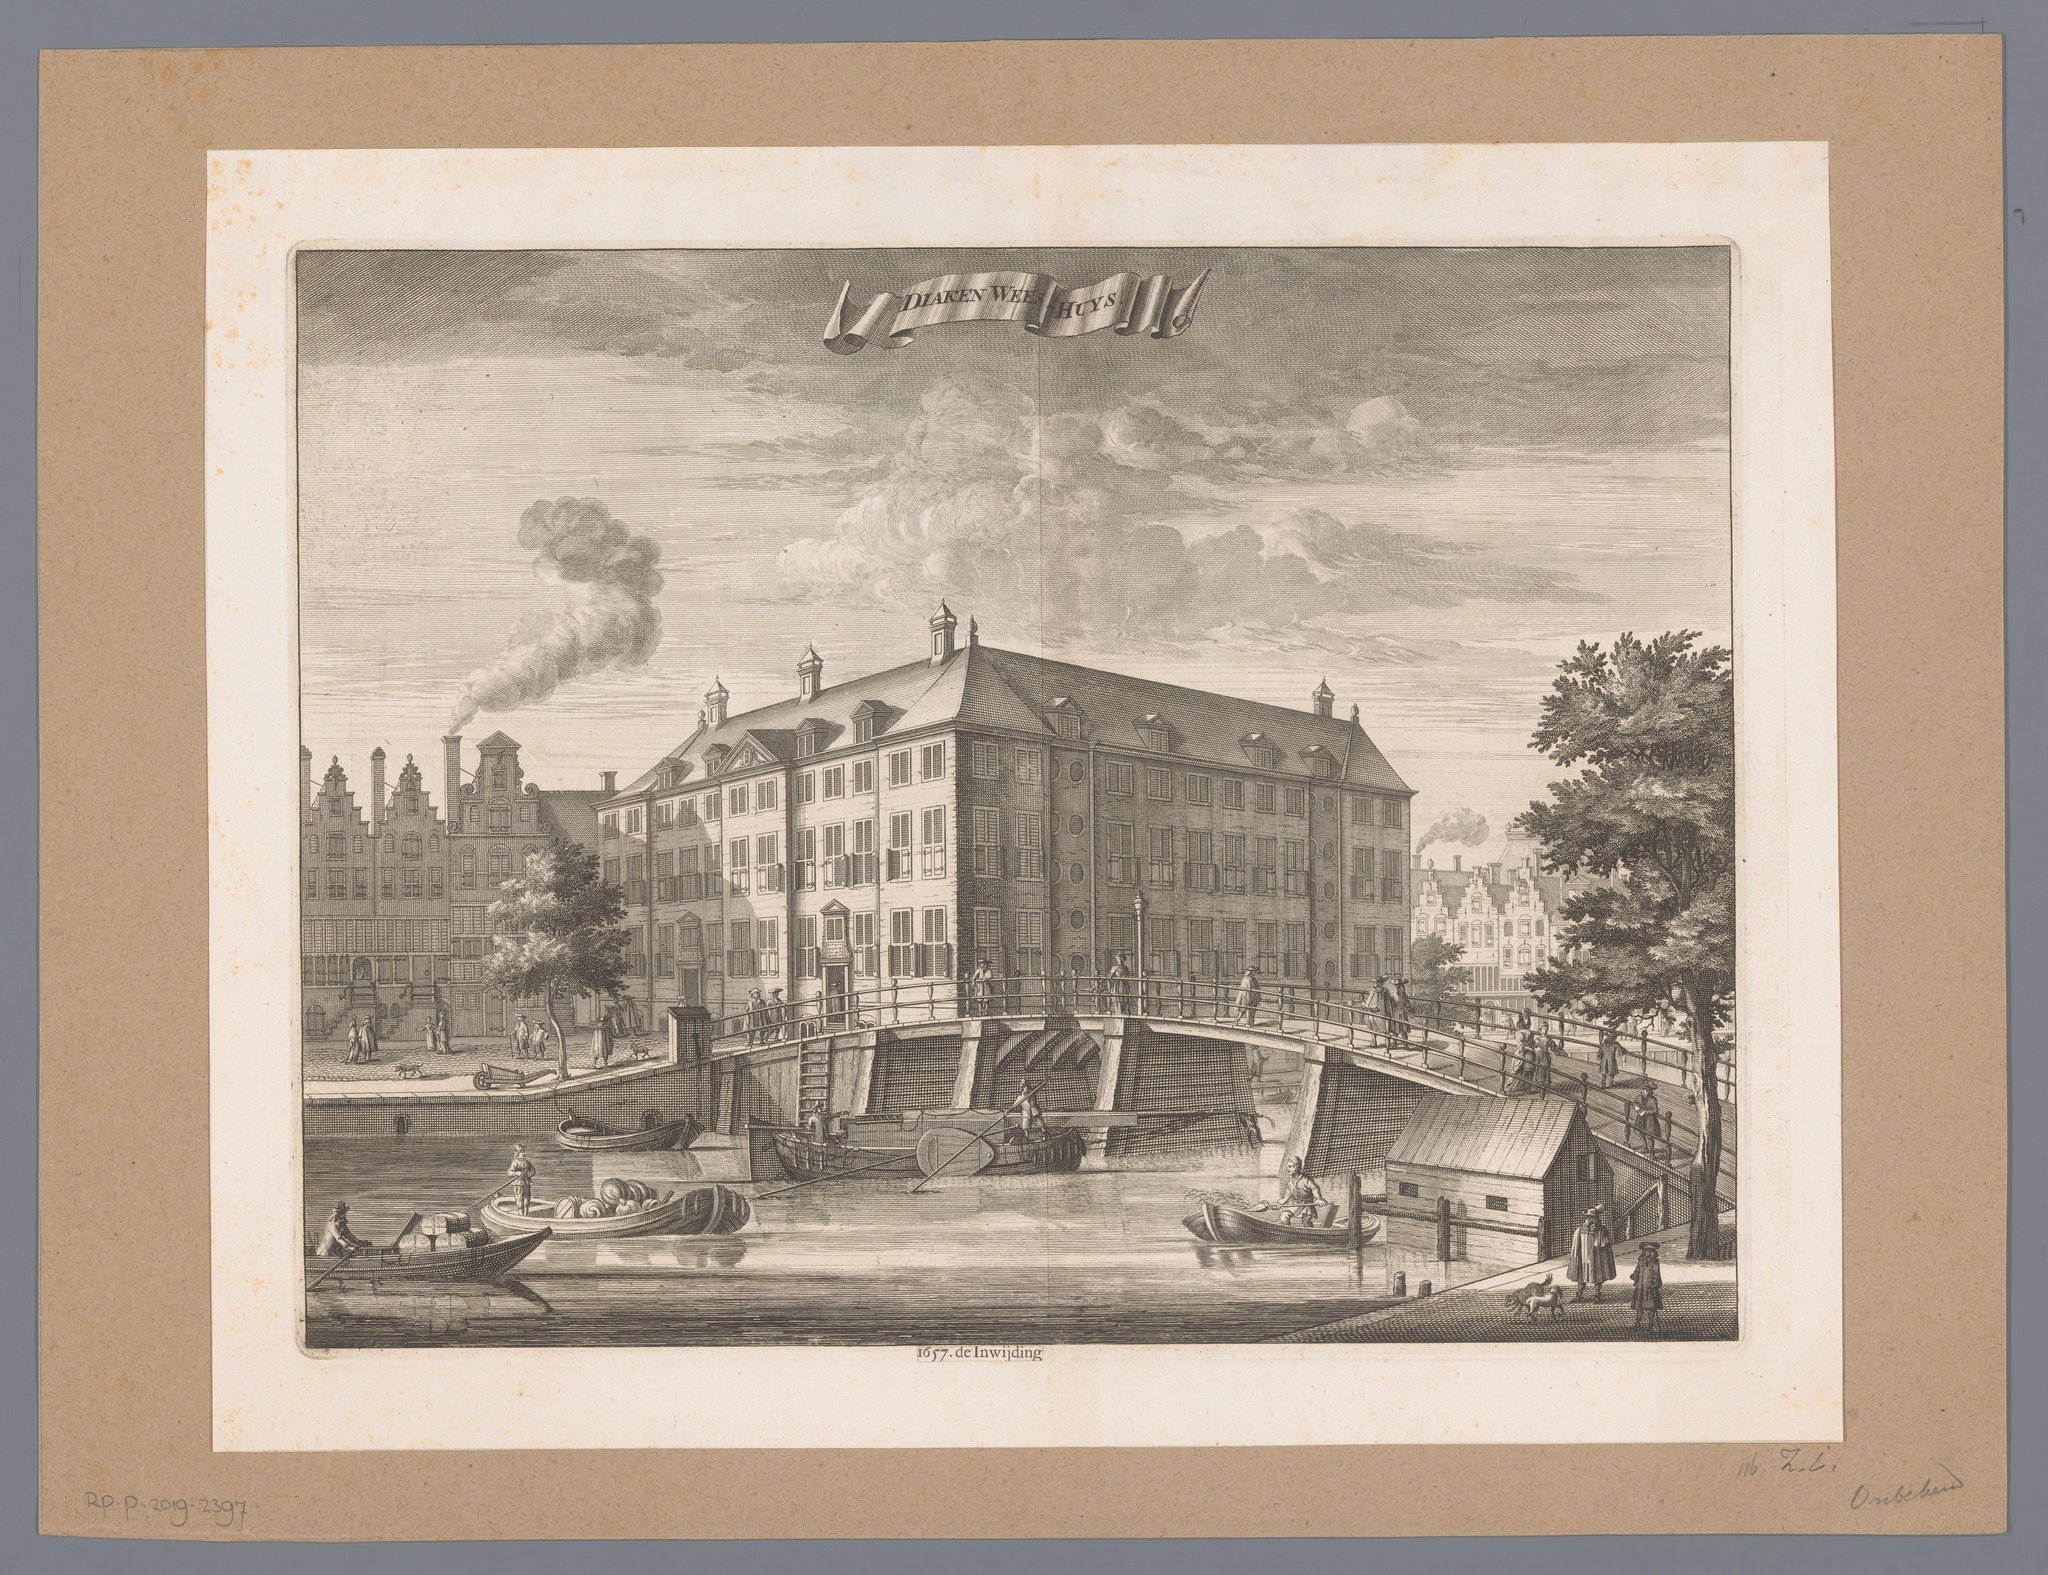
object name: book illustration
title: Gezicht op het Diaconieweeshuis te Amsterdam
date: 1693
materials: paper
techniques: engraving, etching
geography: amsterdam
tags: orphanage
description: Prent uit: Commelin, Caspar. Beschryvinge van Amsterdam (...). 2 dln. Amsterdam: Weduwe Dircksz. Oossaan, 1693, dl. 2, p. 594-595.